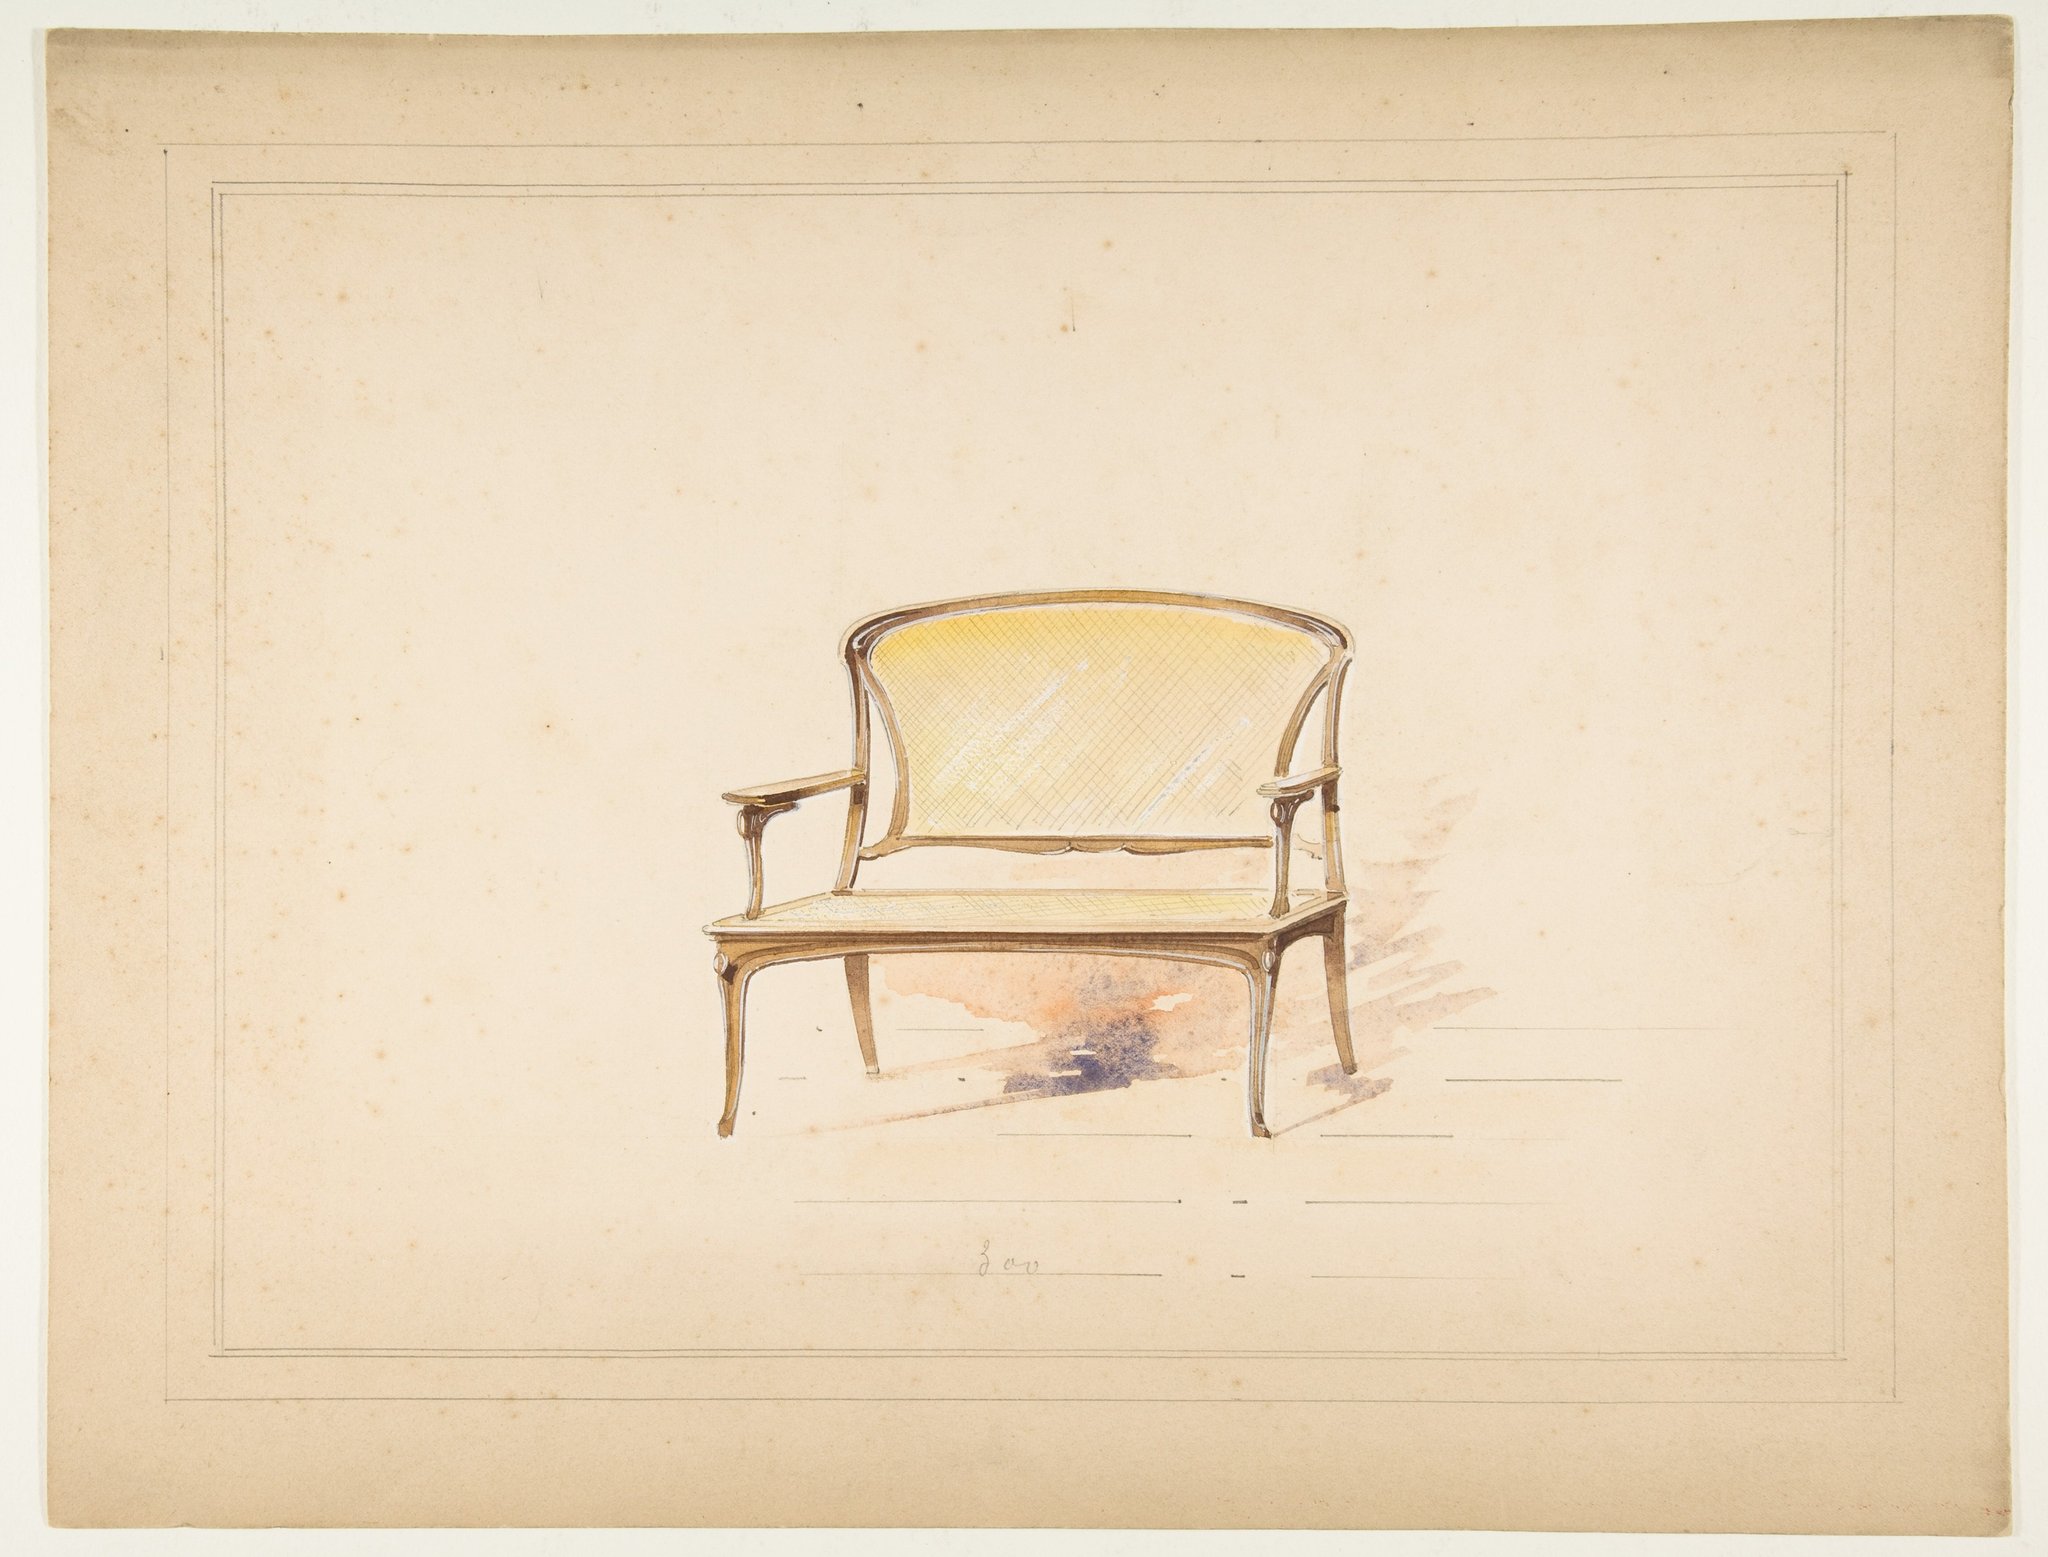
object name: drawing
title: Design for Art Nouveau Loveseat with Caning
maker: anonymous, french, 19th century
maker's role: artist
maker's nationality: french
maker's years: 1800-1900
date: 1801-1900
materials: gouache, graphite, watercolor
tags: furniture